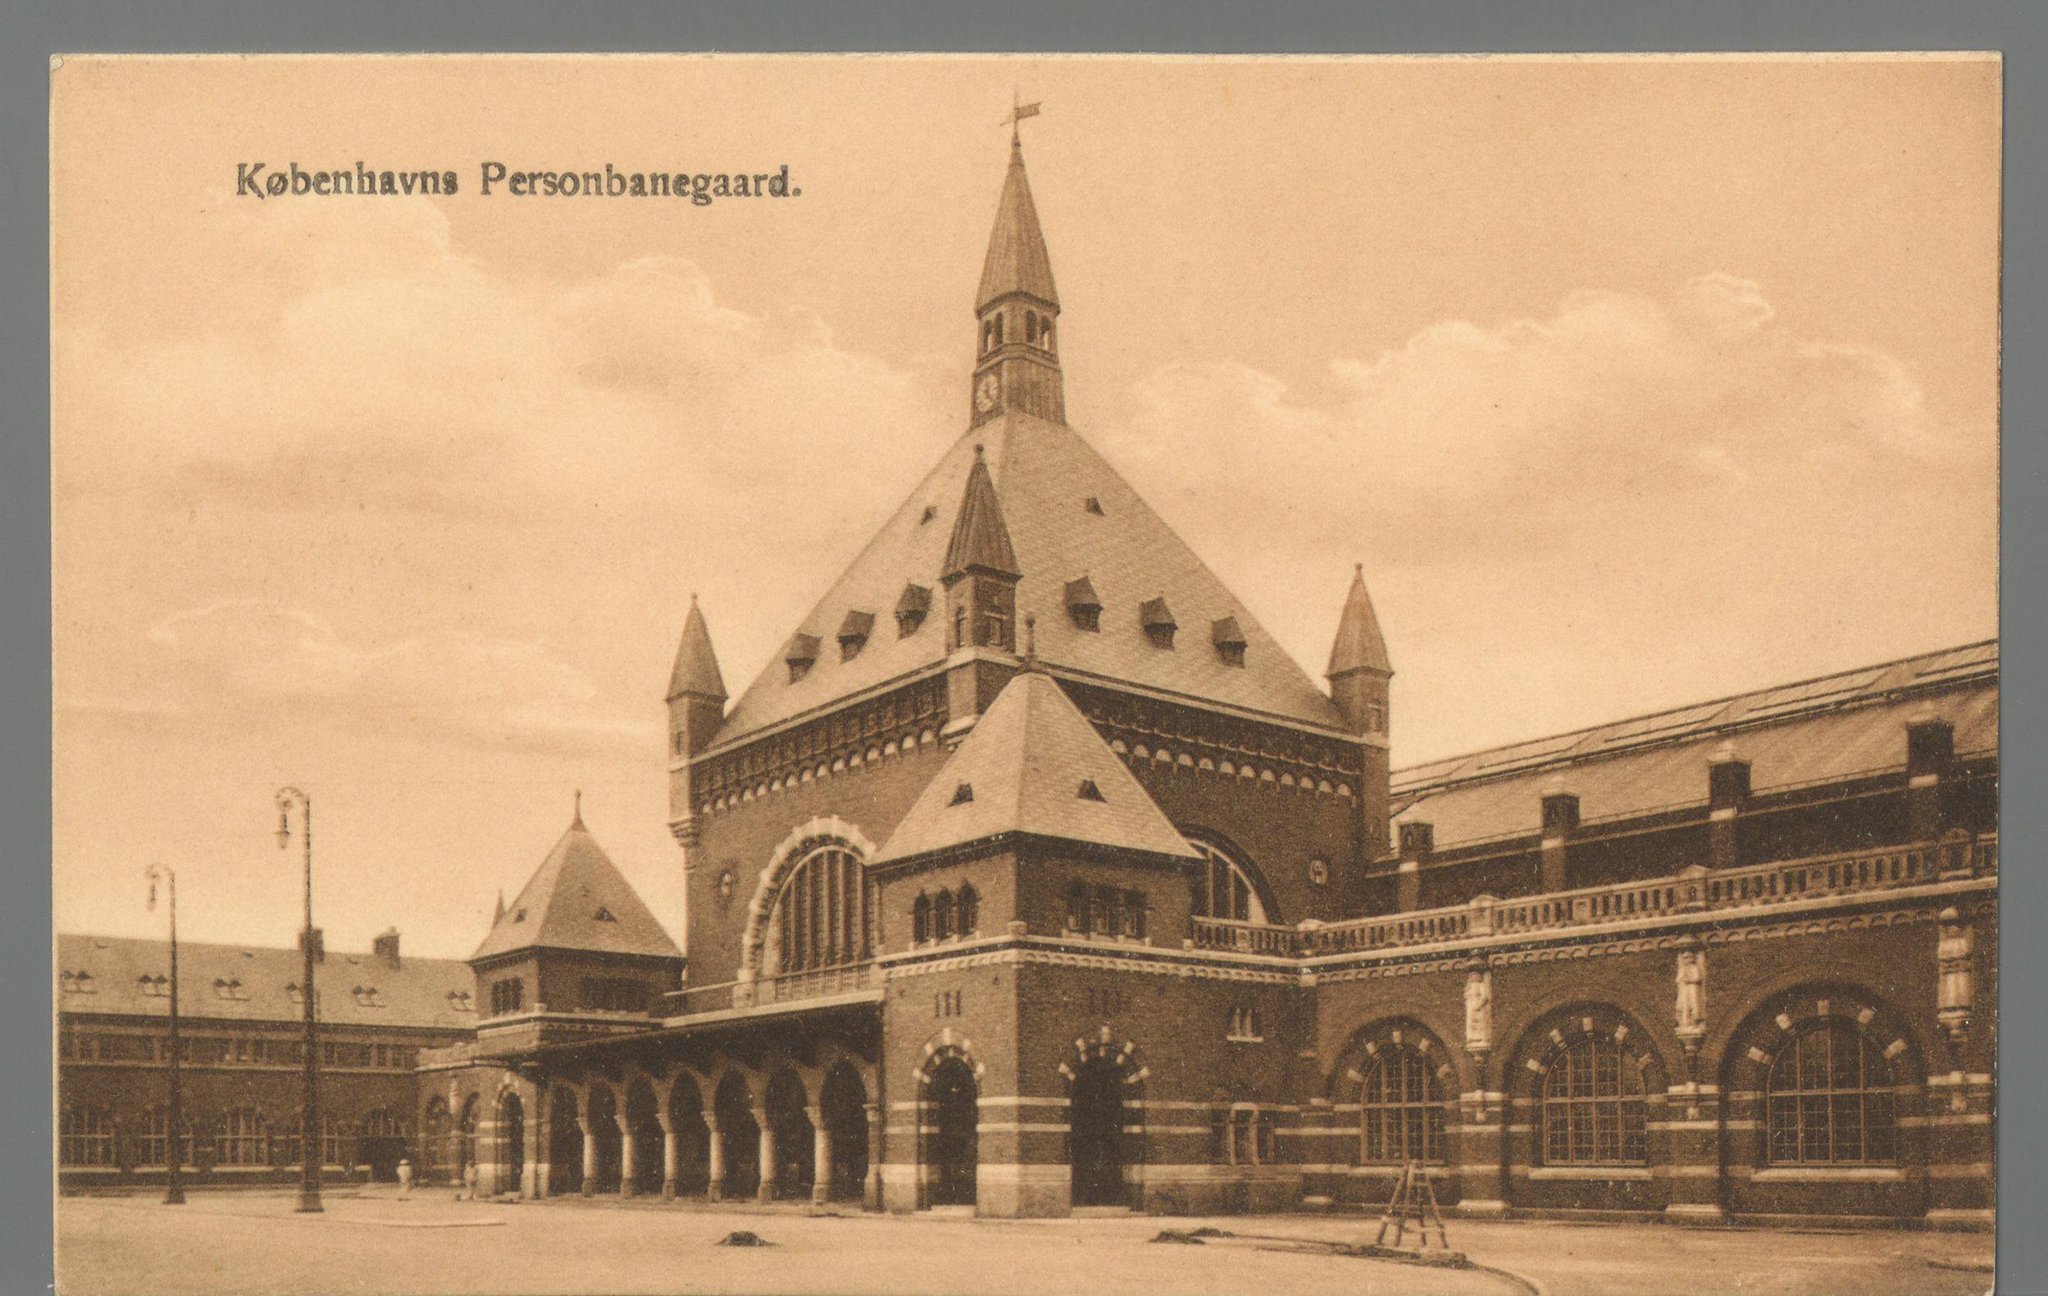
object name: photomechanical print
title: Københavns Personbanegaard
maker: Anonymous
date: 1906-1920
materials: cardboard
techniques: photograph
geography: copenhagen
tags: square, place, circus, etc., station; shelter (railway, tramway), copenhagen (city)